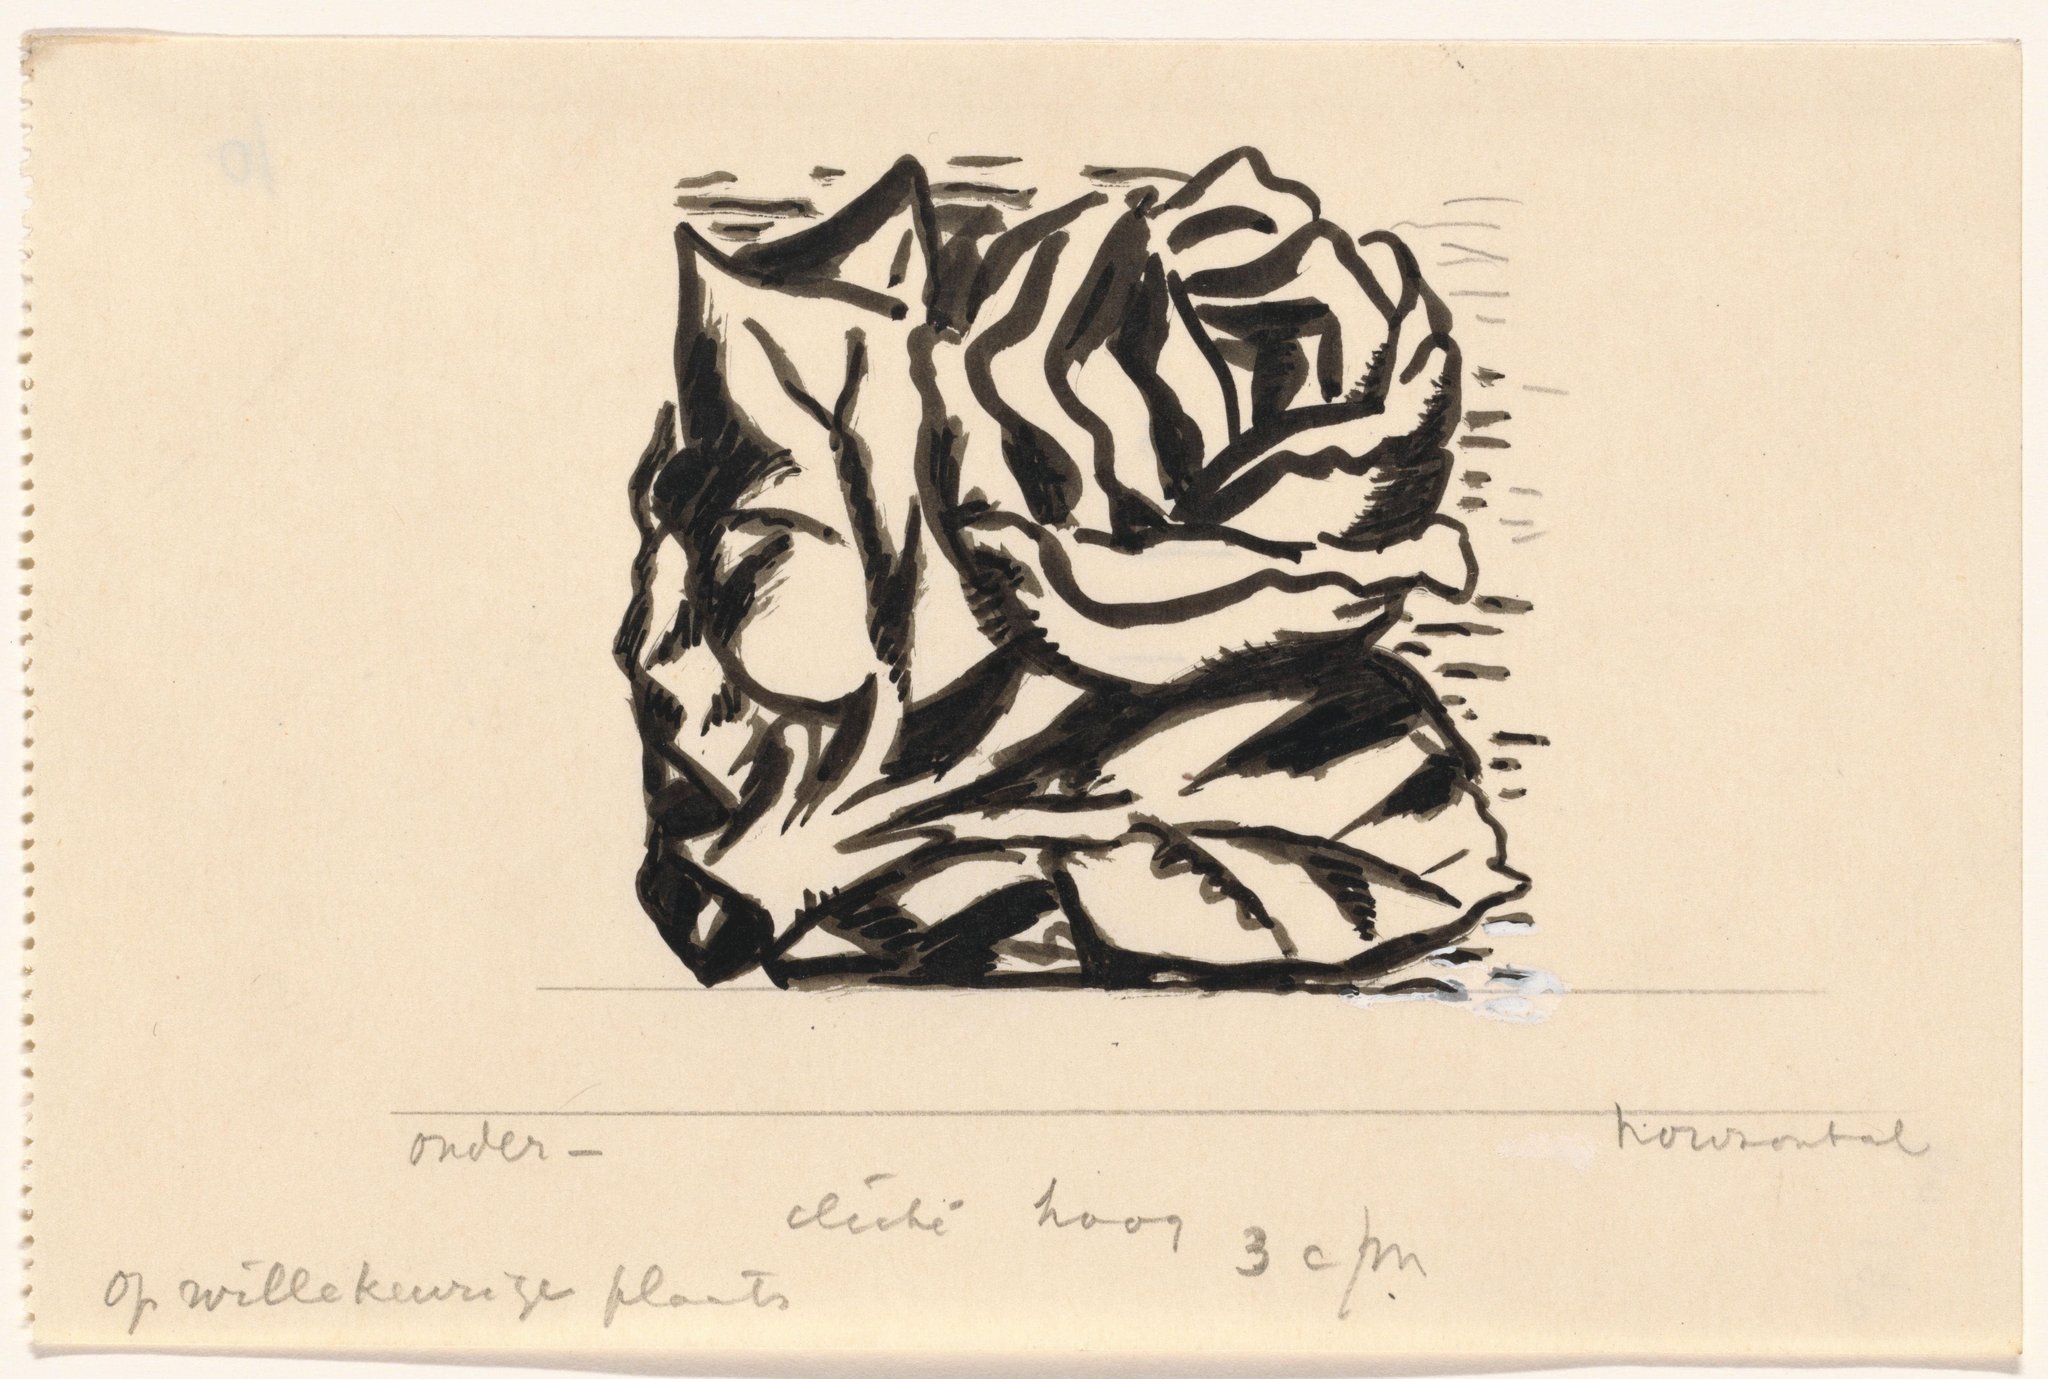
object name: drawing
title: Roos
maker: leo gestel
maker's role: draughtsman, print maker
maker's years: 1881-1941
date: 1934-1936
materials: paint, ink, paper, pencil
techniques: brush, pen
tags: (cohen, van anarchist tot monarchist) specific works of literature (with author, title), flowers: rose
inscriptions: clichéaanwijzing, recto, handgeschreven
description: Ontwerp voor een boekillustratie voor: Cohen, Alexander. Van anarchist tot monarchist. Amsterdam: De Steenuil, 1936.